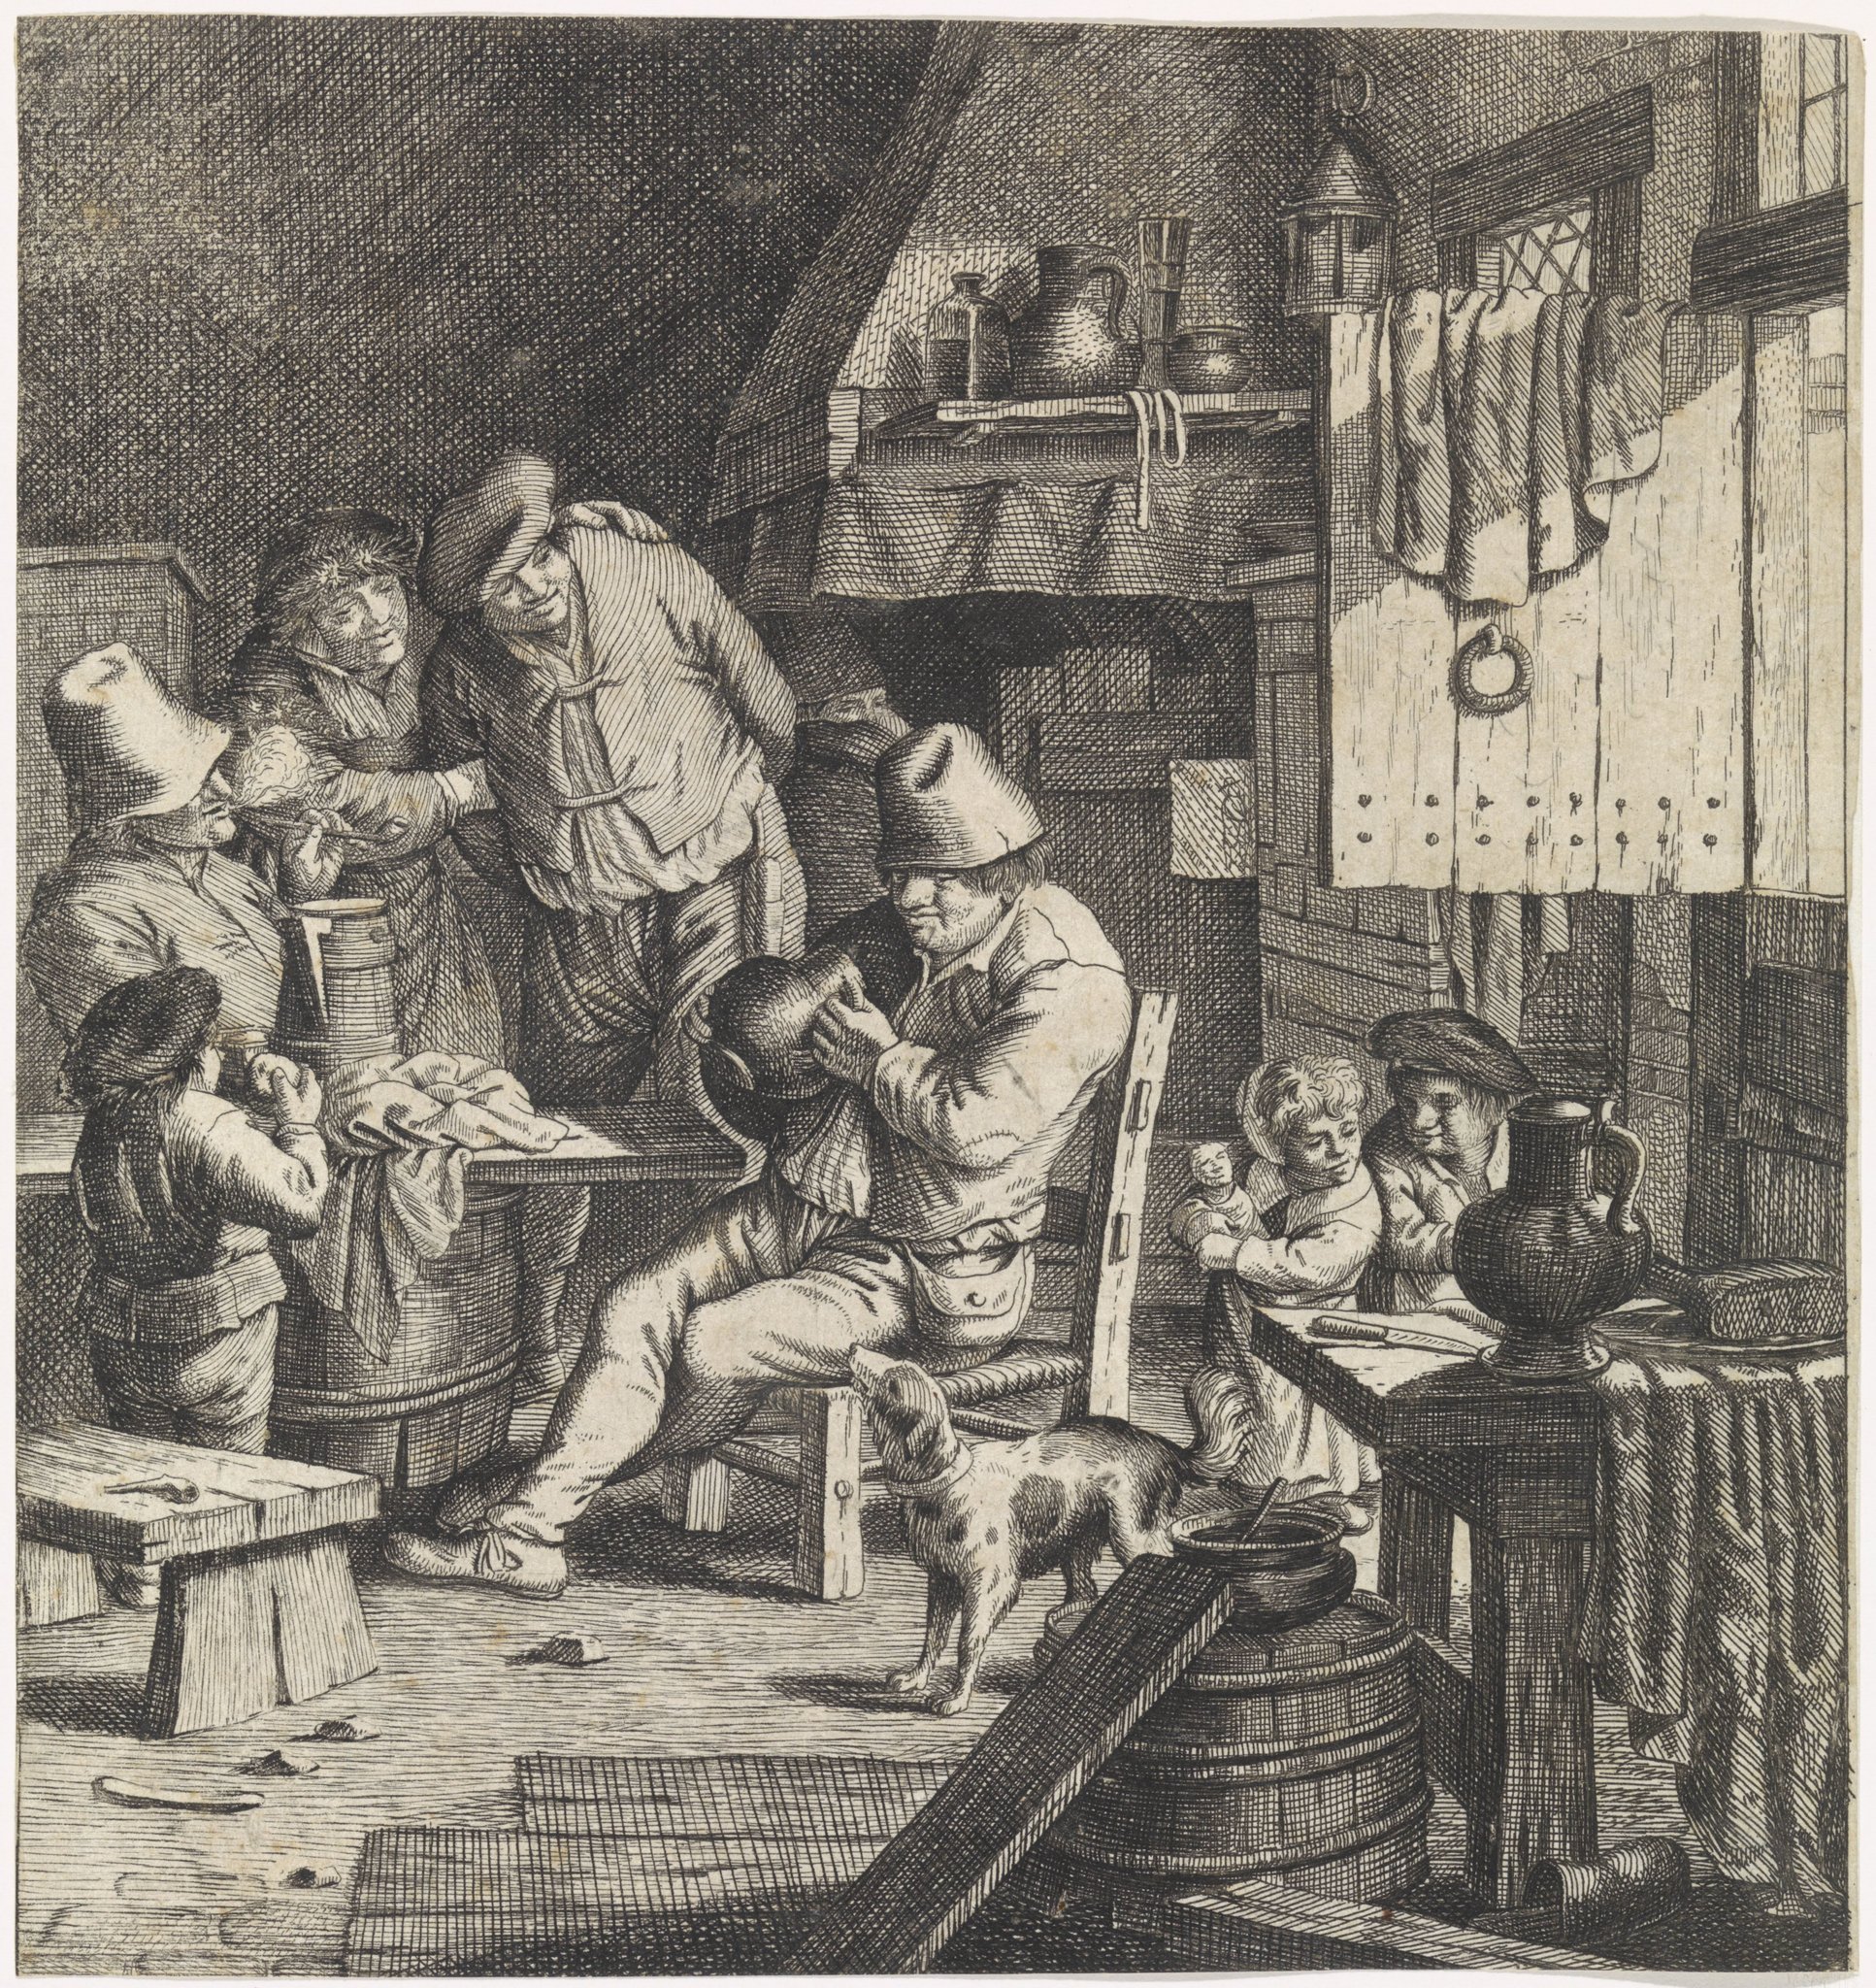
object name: print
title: Boereninterieur met een boer met een kruik in handen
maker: justus van den nijpoort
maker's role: draughtsman, print maker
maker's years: 1625-1692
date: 1635-1692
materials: paper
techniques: engraving, etching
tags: jar, jug (used as drinking-vessel), farmers, interior of the house, dog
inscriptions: collector's mark: Lugt 2165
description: In een interieur zit een boer op een stoel met een kruik in zijn handen. Drie mannen links kijken naar hem. Bij de tafel, bestaande uit een ton en een plank, staat eveneens een jongen. Een hond kijkt naar het gezelschap op. Rechts bij een andere tafel staan een meisje met een pop in haar armen en een jongen.